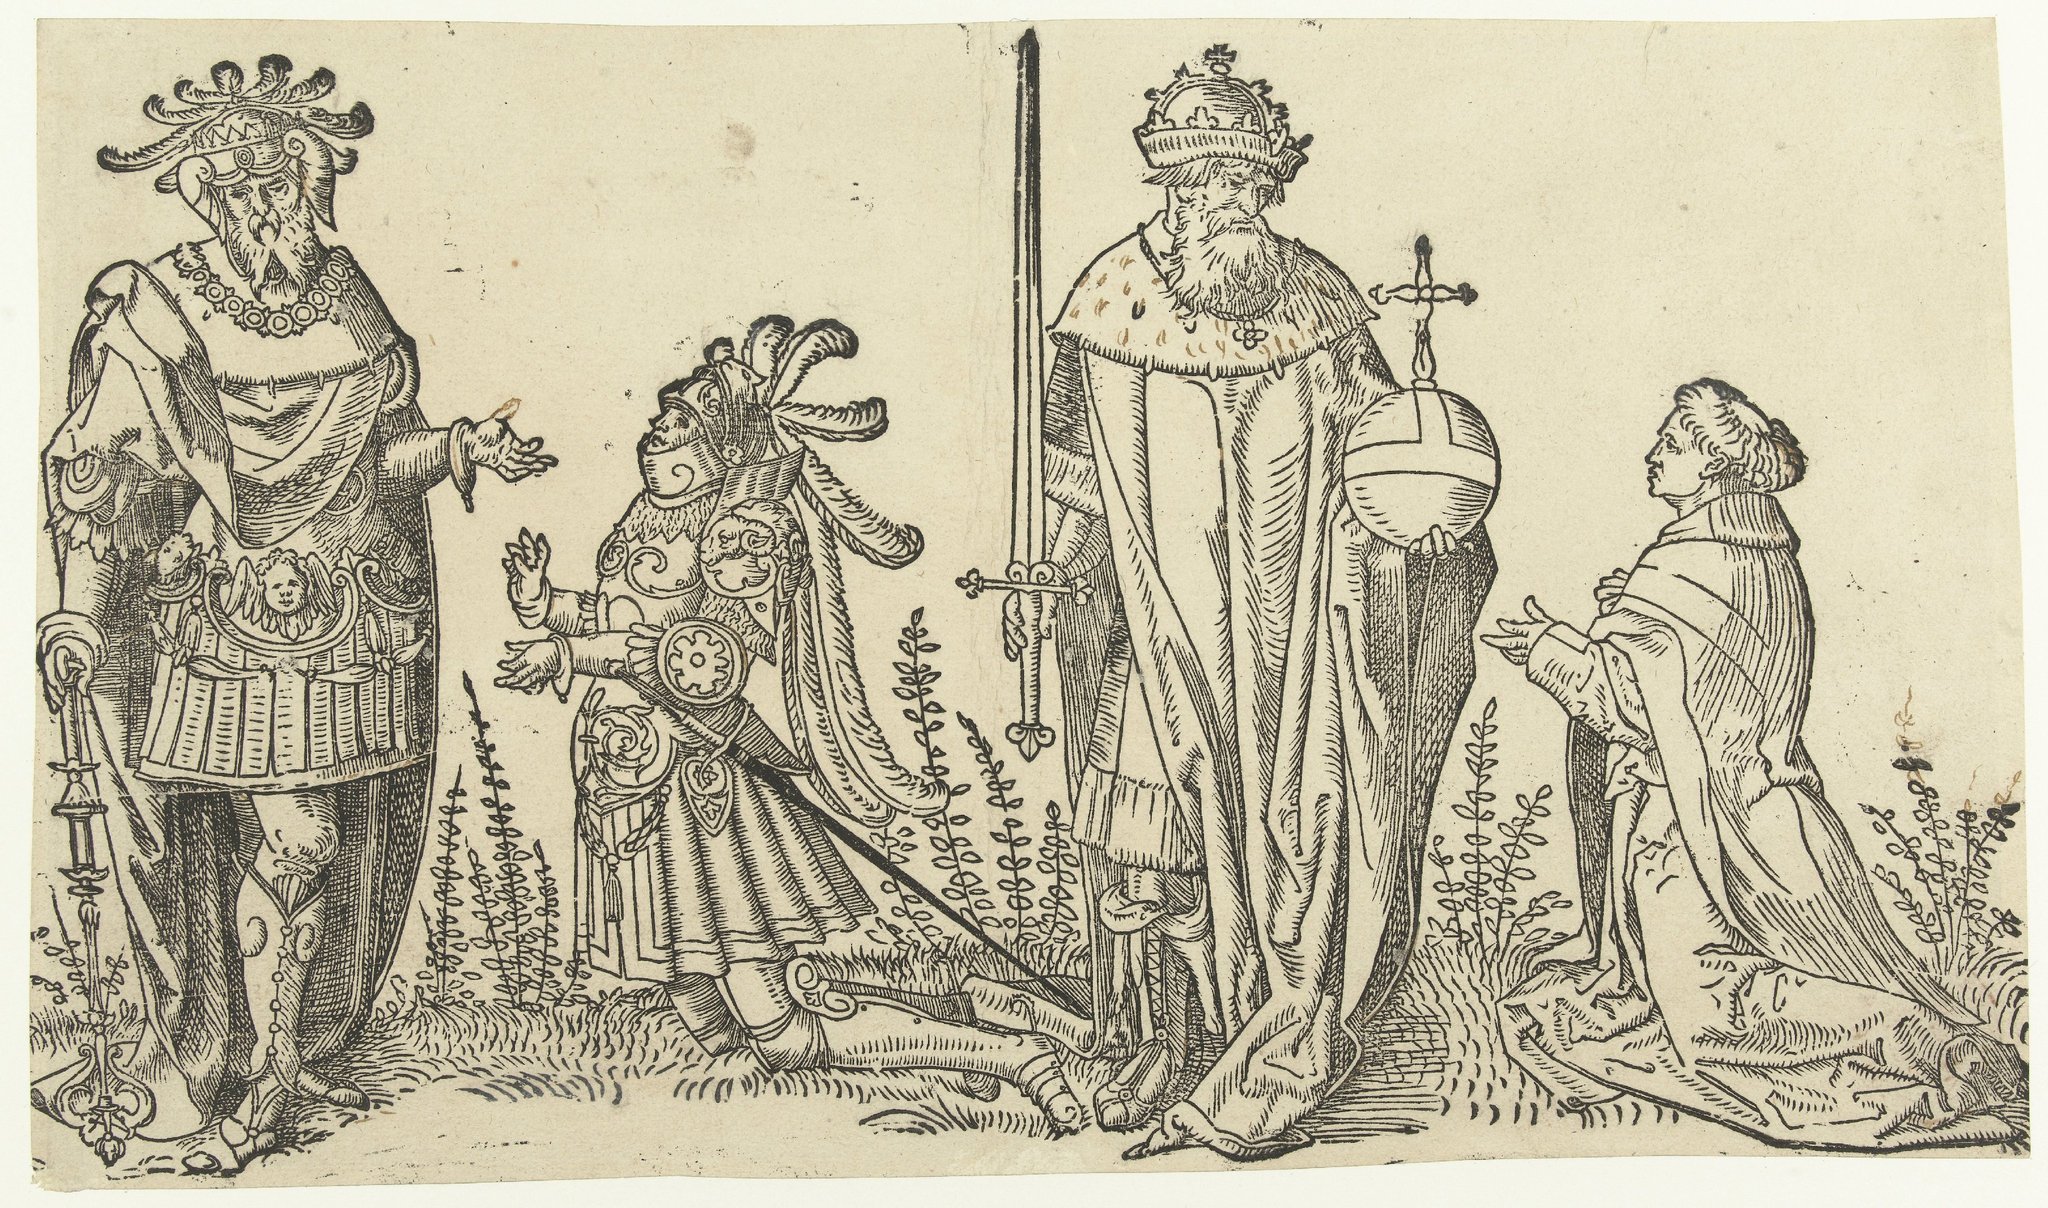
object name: print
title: Koning Arthur met ridder en Keizer Karel de Grote met priester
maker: Anonymous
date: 1500-1549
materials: paper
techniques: pen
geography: low countries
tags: charlemagne (holy roman emperor), king arthur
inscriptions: collector's mark: Lugt 240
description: Koning Arthur met geknielde ridder en Keizer Karel de Grote met geknielde priester. De Ridder en priester zijn twee van de vier vertegenwoordigers van de verschillende standen.